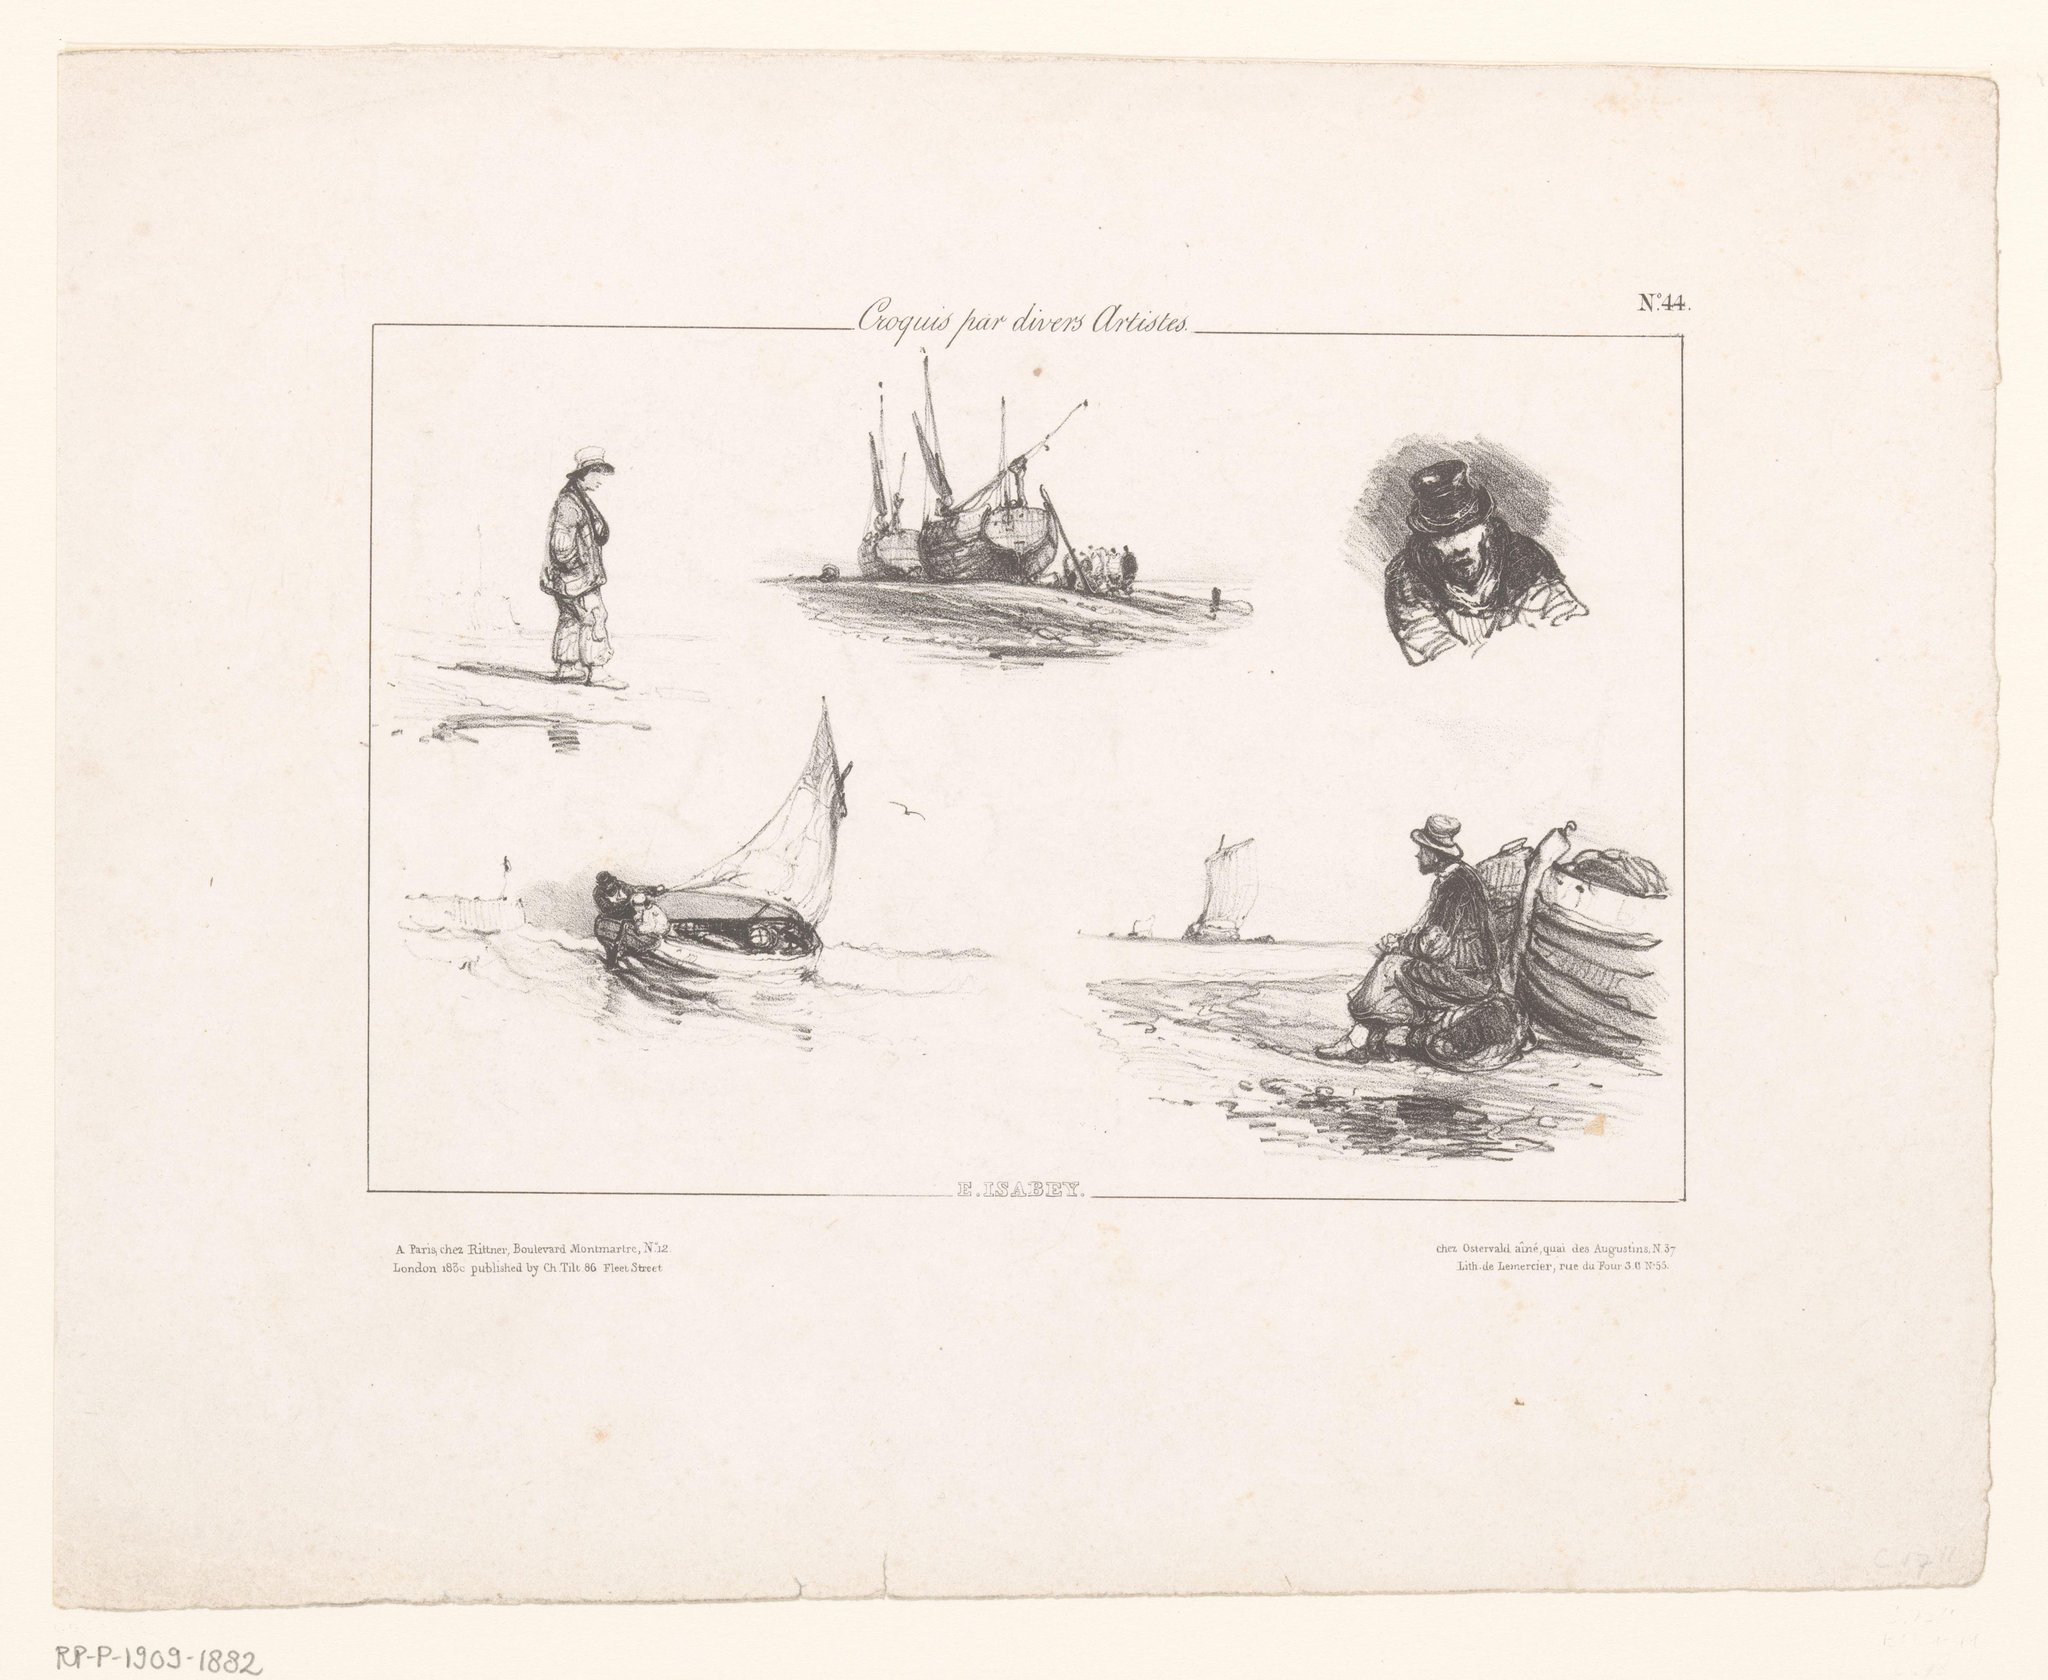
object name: print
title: Schetsen van verschillende kunstenaars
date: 1830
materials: paper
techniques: lithograph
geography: paris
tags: sailing-ship, sailing-boat, beach, sea and coastal fishery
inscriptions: collector's mark: Lugt 2228a